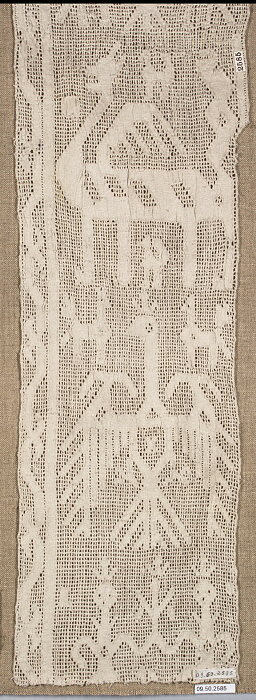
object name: fragment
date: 1501-1700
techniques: embroidery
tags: animals